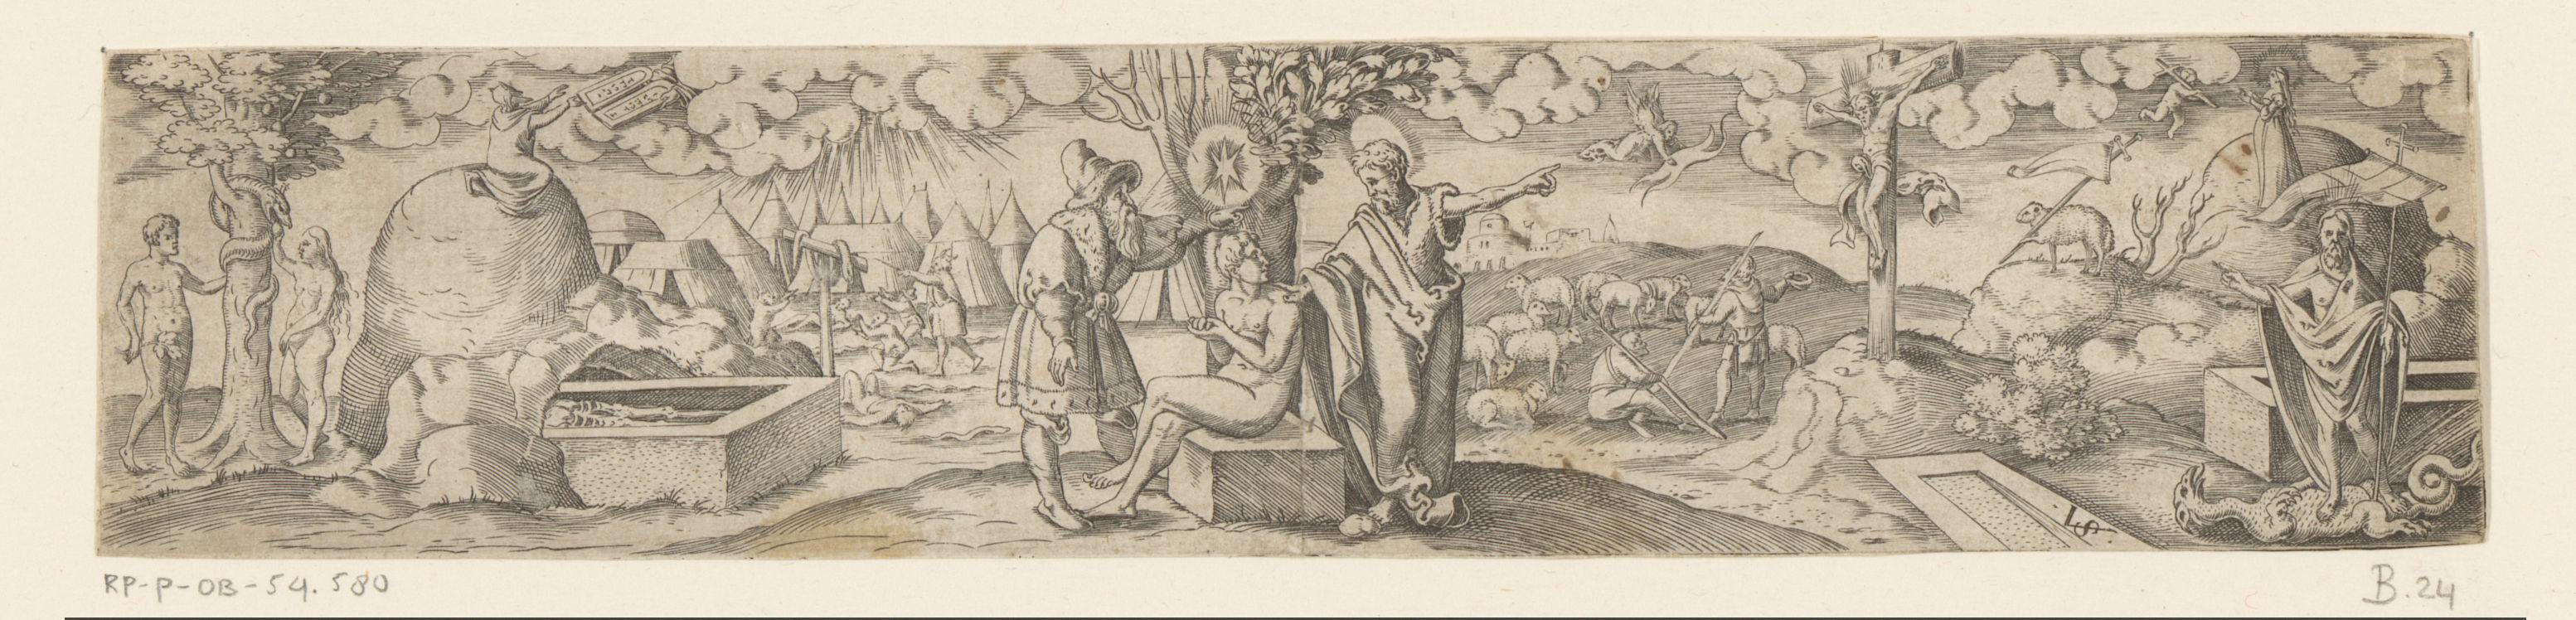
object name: print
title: Wet en evangelie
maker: virgilius solis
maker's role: draughtsman, print maker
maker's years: 1514-1562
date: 1524-1562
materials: paper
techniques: engraving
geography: nuremberg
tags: christ standing on or near the tomb ~ events after the resurrection, the brazen serpent (numbers 21:4-9), annunciation of christ's birth to the shepherds (and/or shepherdesses) at night; a host of singing angels in the air, moses receives the tables of the law from god, eve takes the fruit from the serpent (or the tree) in the presence of adam (who may be trying to stop her), christ triumphing over devil(s), the crucifixion of christ: christ's death on the cross; golgotha (matthew 27:45-58; mark 15:33-45; luke 23:44-52; john 19:25-38)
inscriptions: number: ‘7’, collector's mark: Lugt 2228